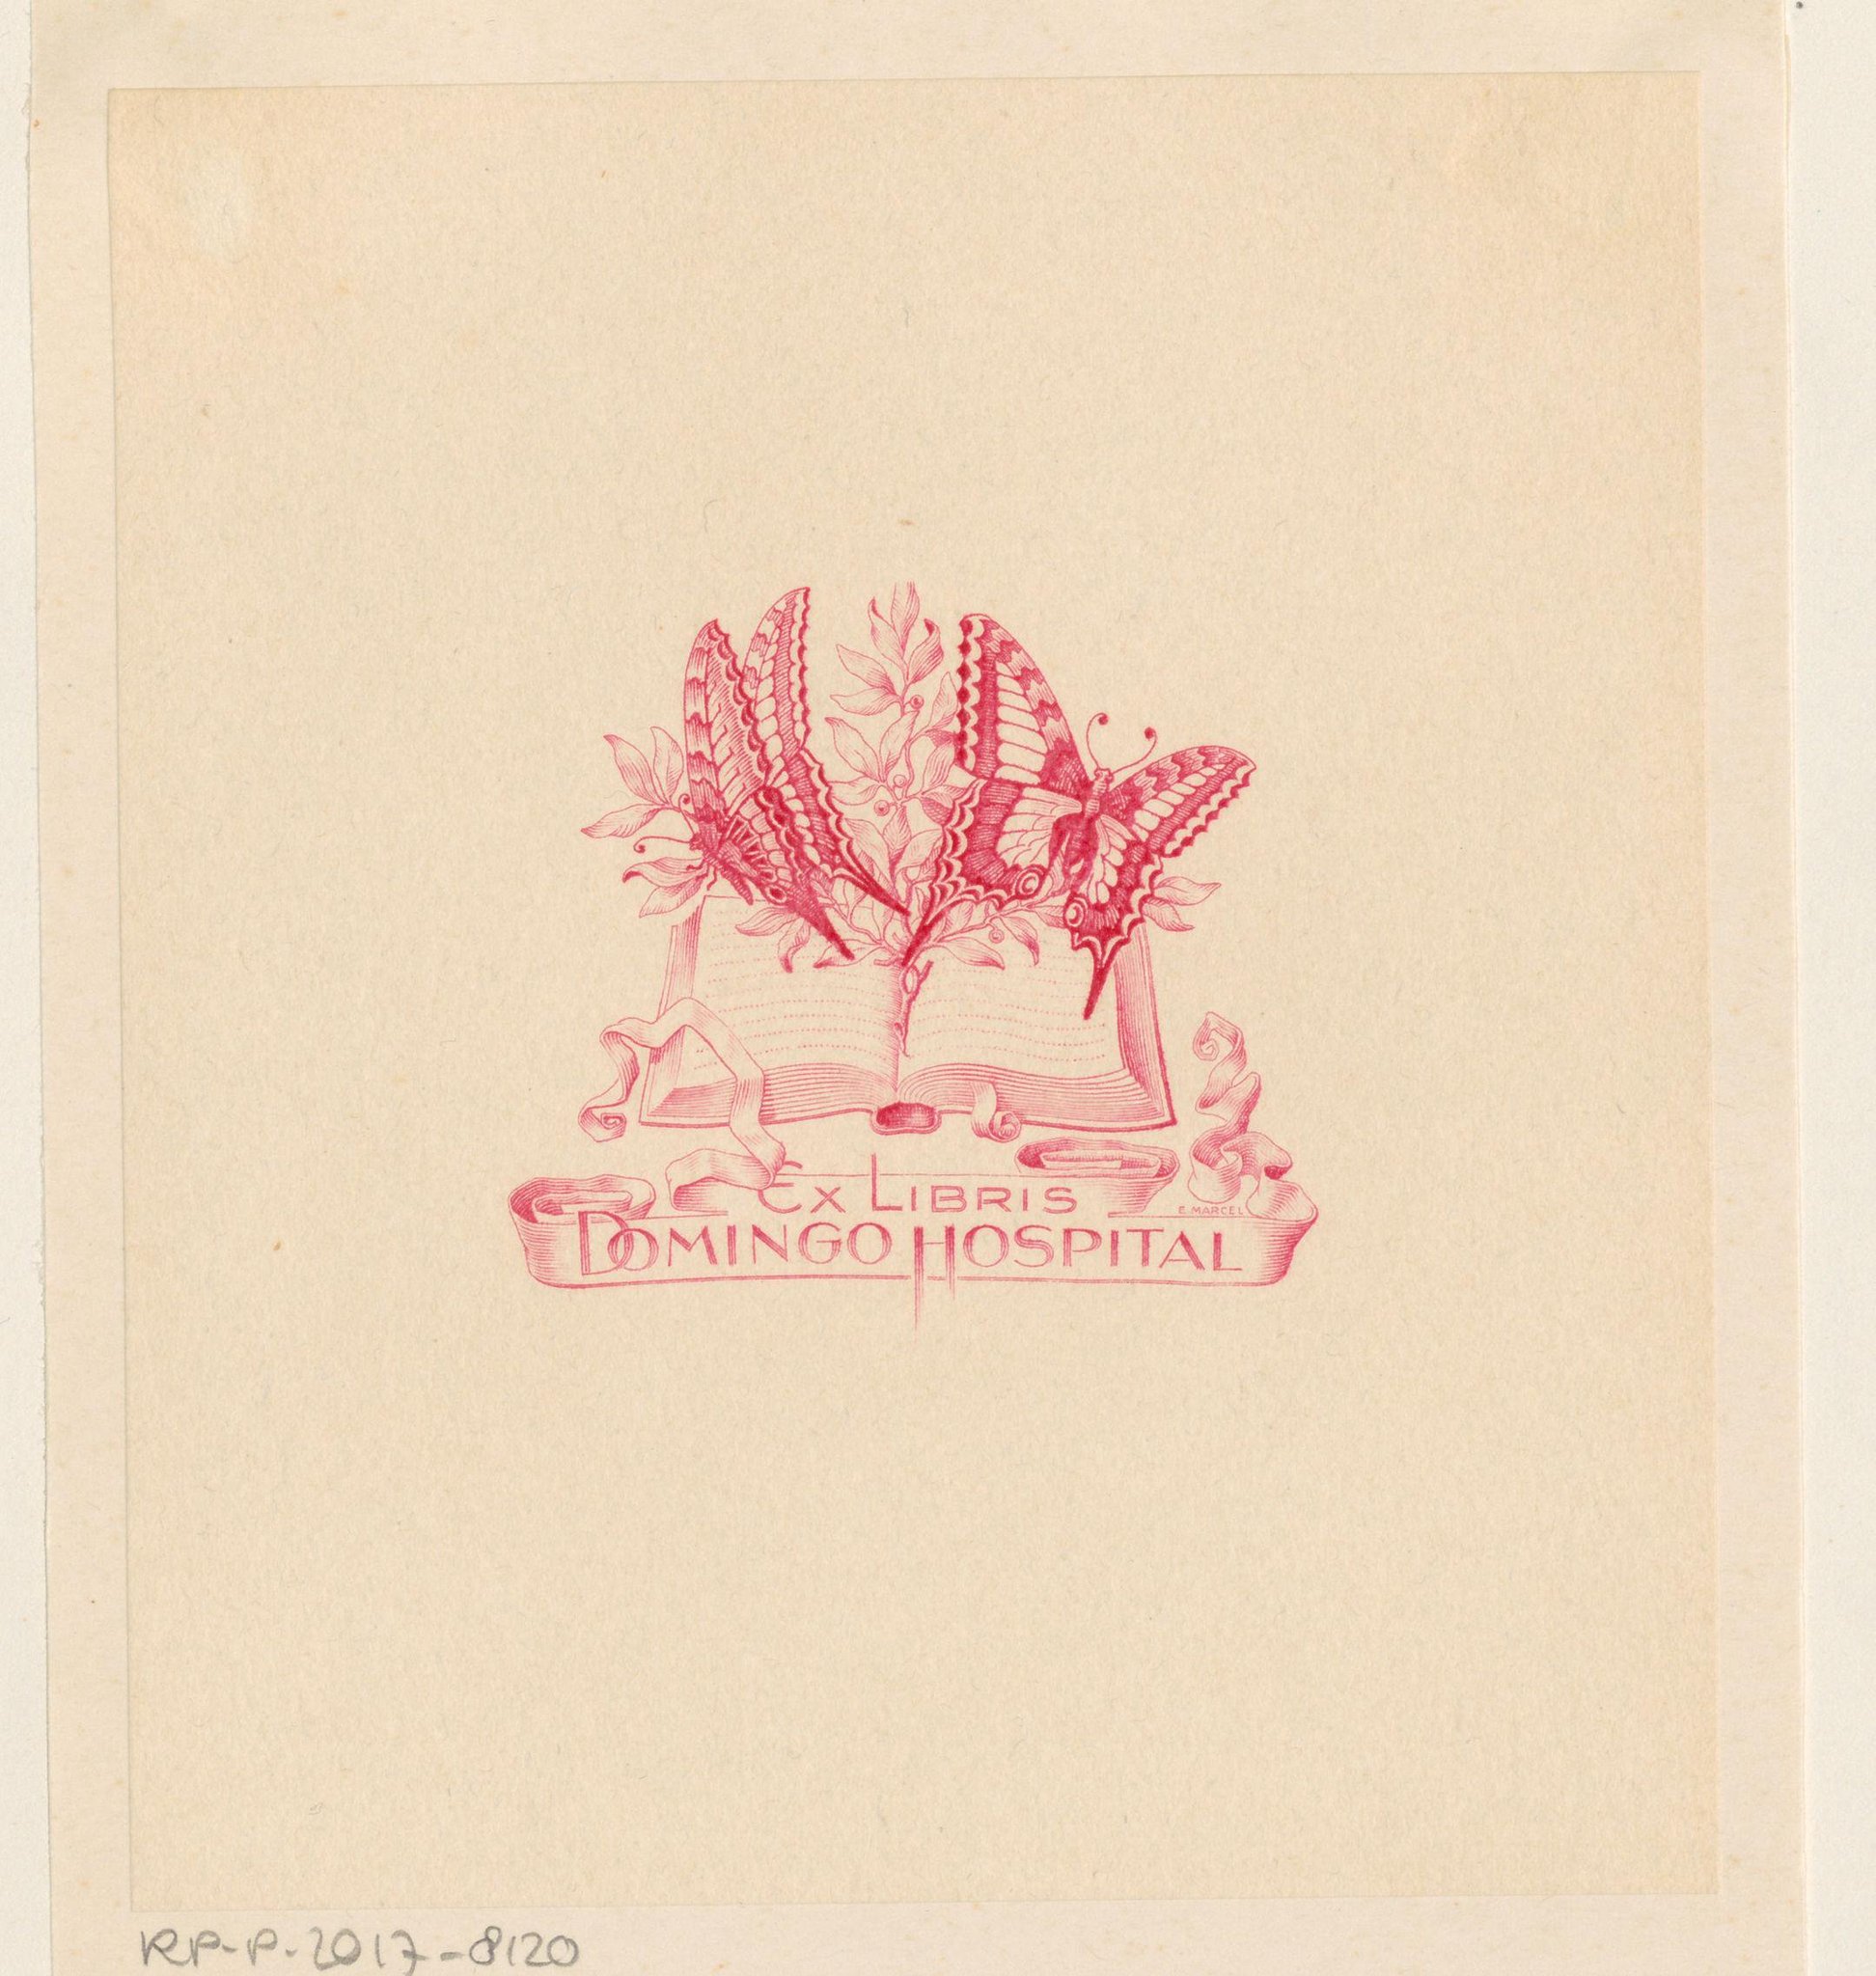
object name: bookplate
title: Ex libris van Domingo Hospital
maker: e. marcel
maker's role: print maker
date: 1944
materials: paper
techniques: printing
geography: spain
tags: book, insects: butterfly